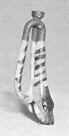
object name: ceramic horn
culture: italian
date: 1801-1900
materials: pottery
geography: italy